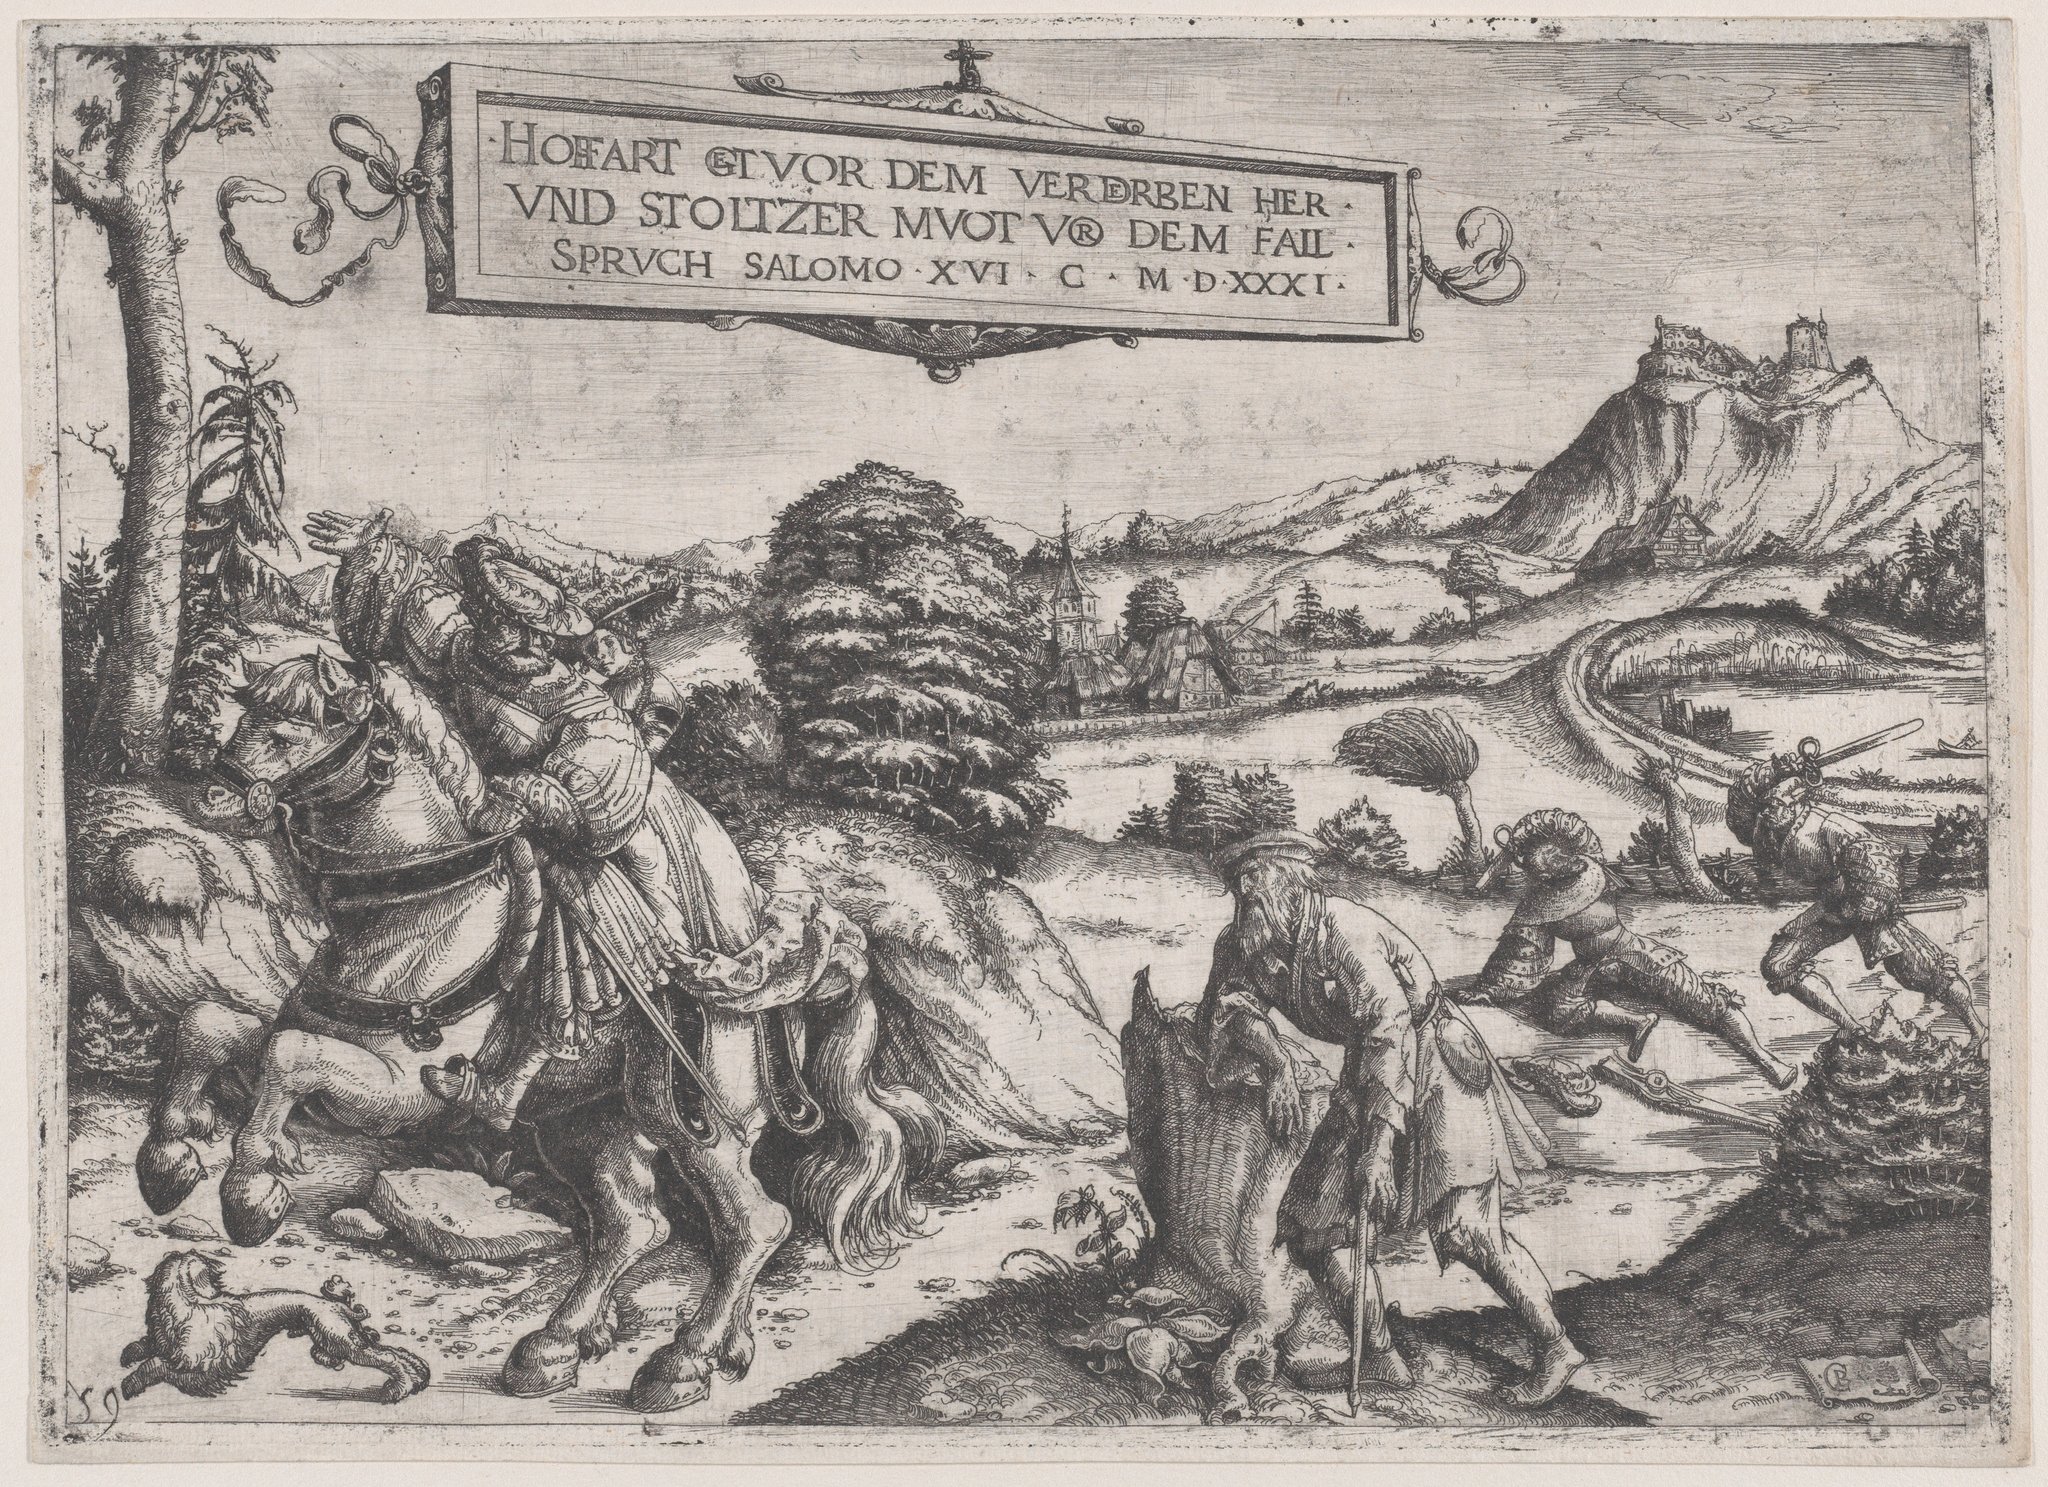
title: Pride goeth before a fall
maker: christoph bockstorffer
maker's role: artist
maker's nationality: german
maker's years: 1475-1558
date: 1531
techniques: etching